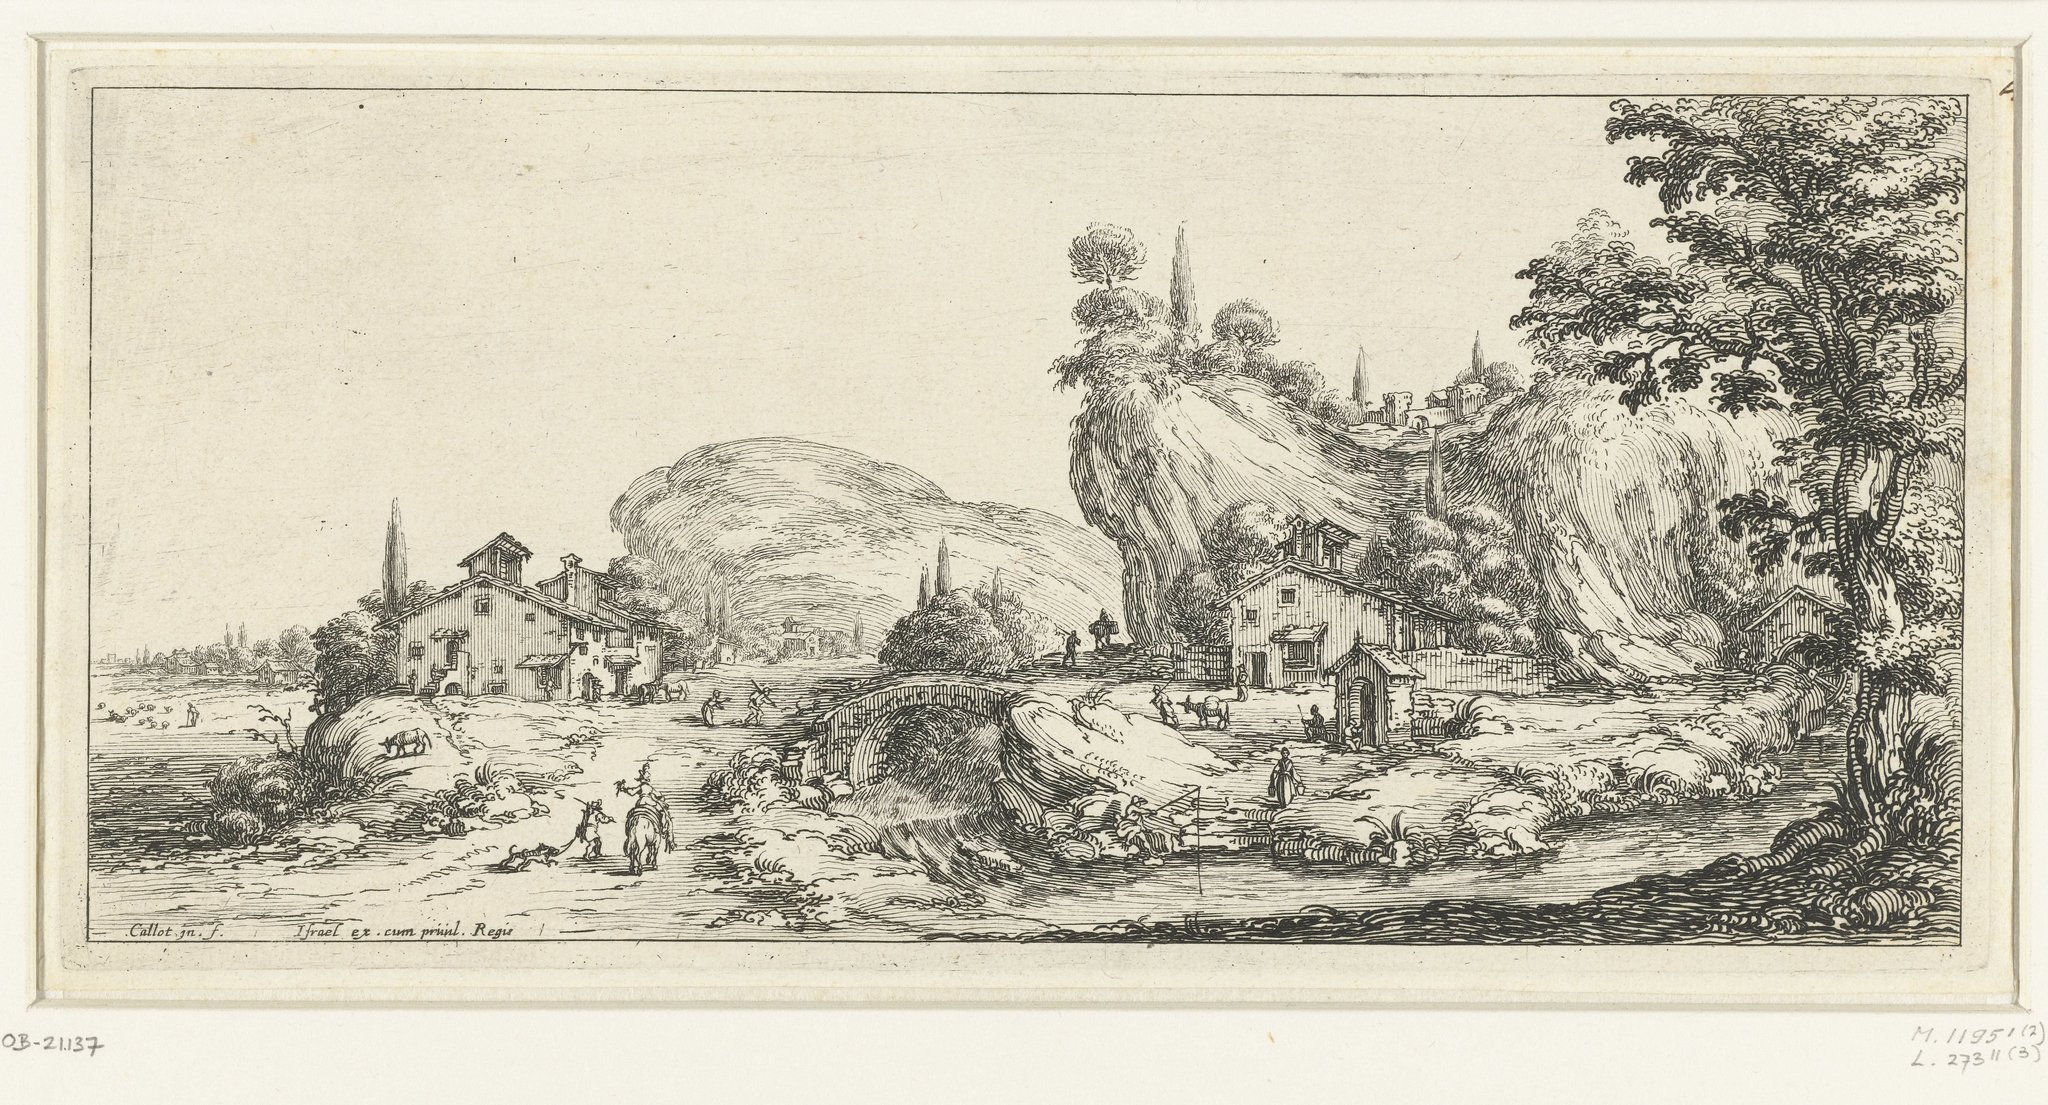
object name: print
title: Elf Italiaanse landschappen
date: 1628-1635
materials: paper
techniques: etching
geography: paris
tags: city-view, and landscape with man-made constructions, river, sports, games ~ animals (+ hunting with falcon, hawk; falconry), mountains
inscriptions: collector's mark: Lugt 240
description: In een bergachtig landschap met enkele huizen en een rivier rijdt een valkenier met zijn buit, zijn valk, zijn knecht en zijn honden. Deze prent is onderdeel van een serie van 11 Italiaanse (waarschijnlijk voornamelijk Florentijnse) landschappen (12 incl. titelprent).